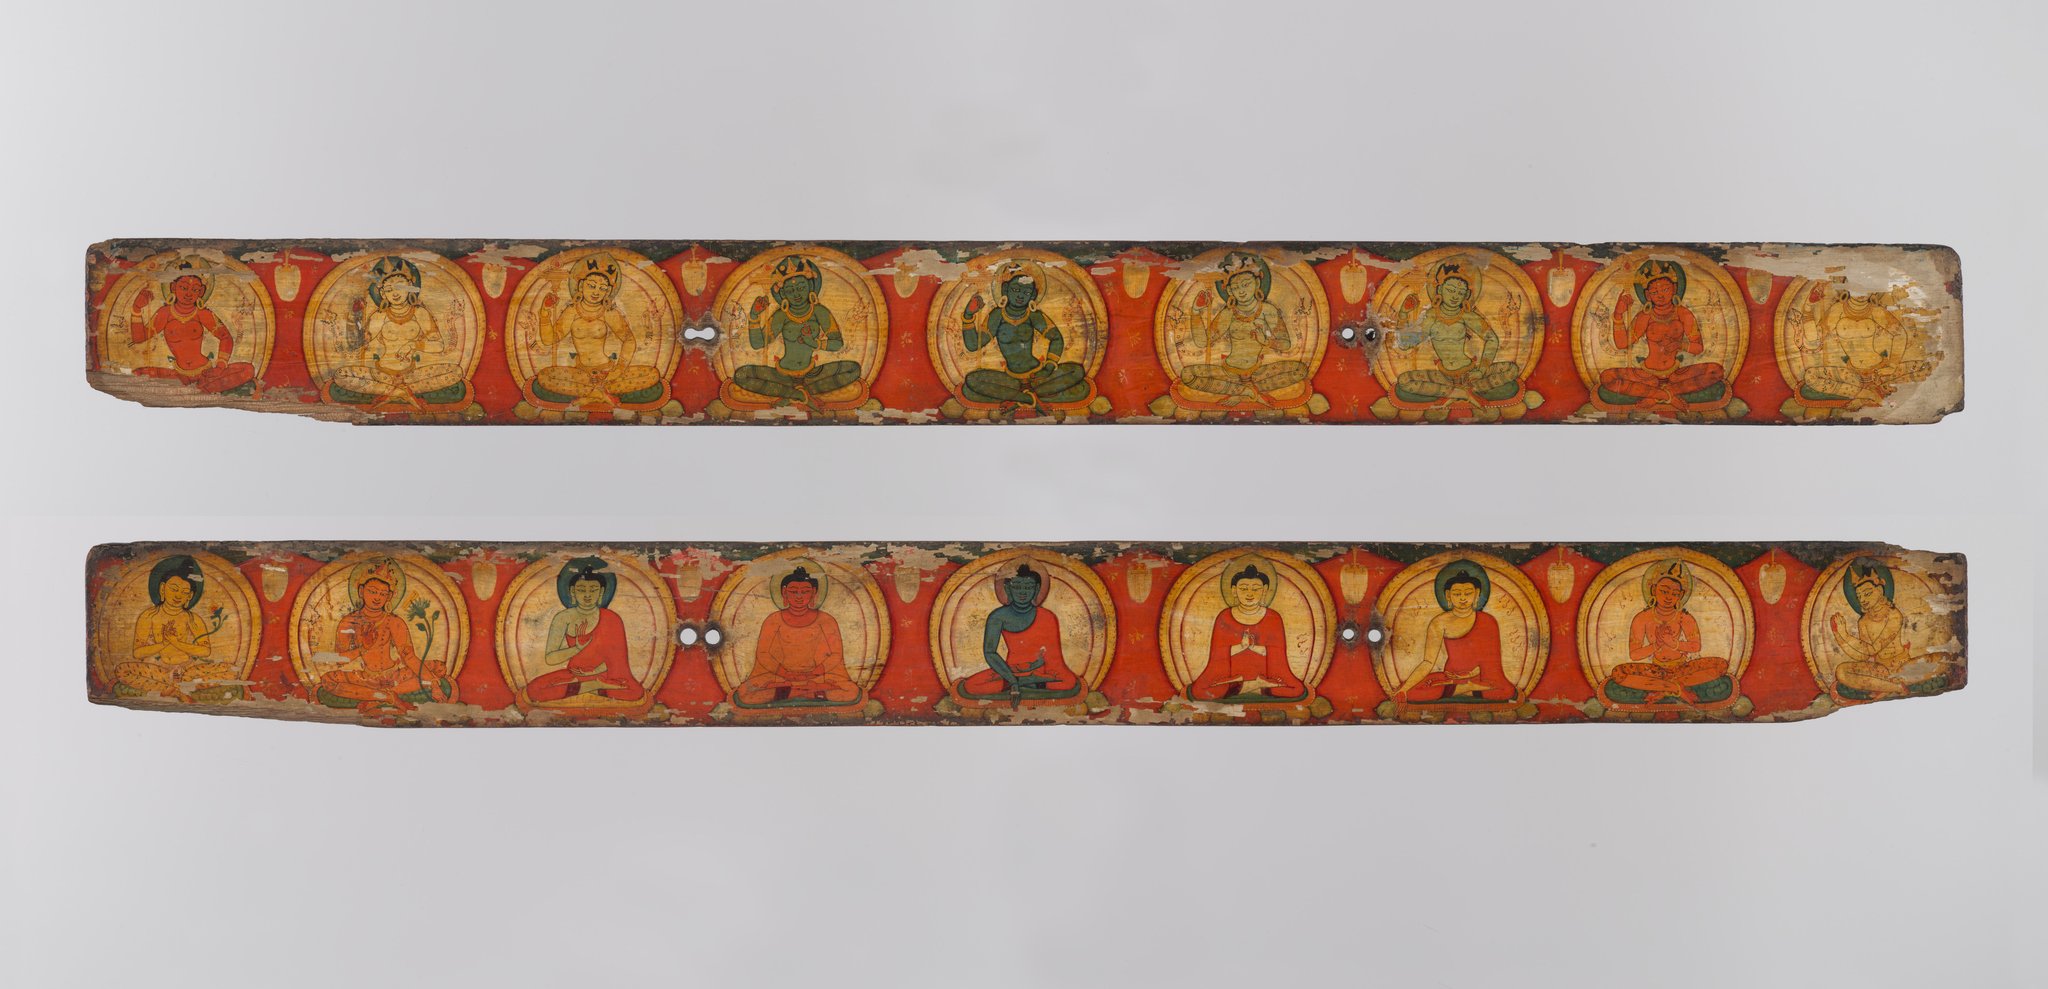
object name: manuscript cover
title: Pair of Manuscript Covers with Buddhist Deities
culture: nepali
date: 1067-1100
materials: wood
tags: buddhism,deities